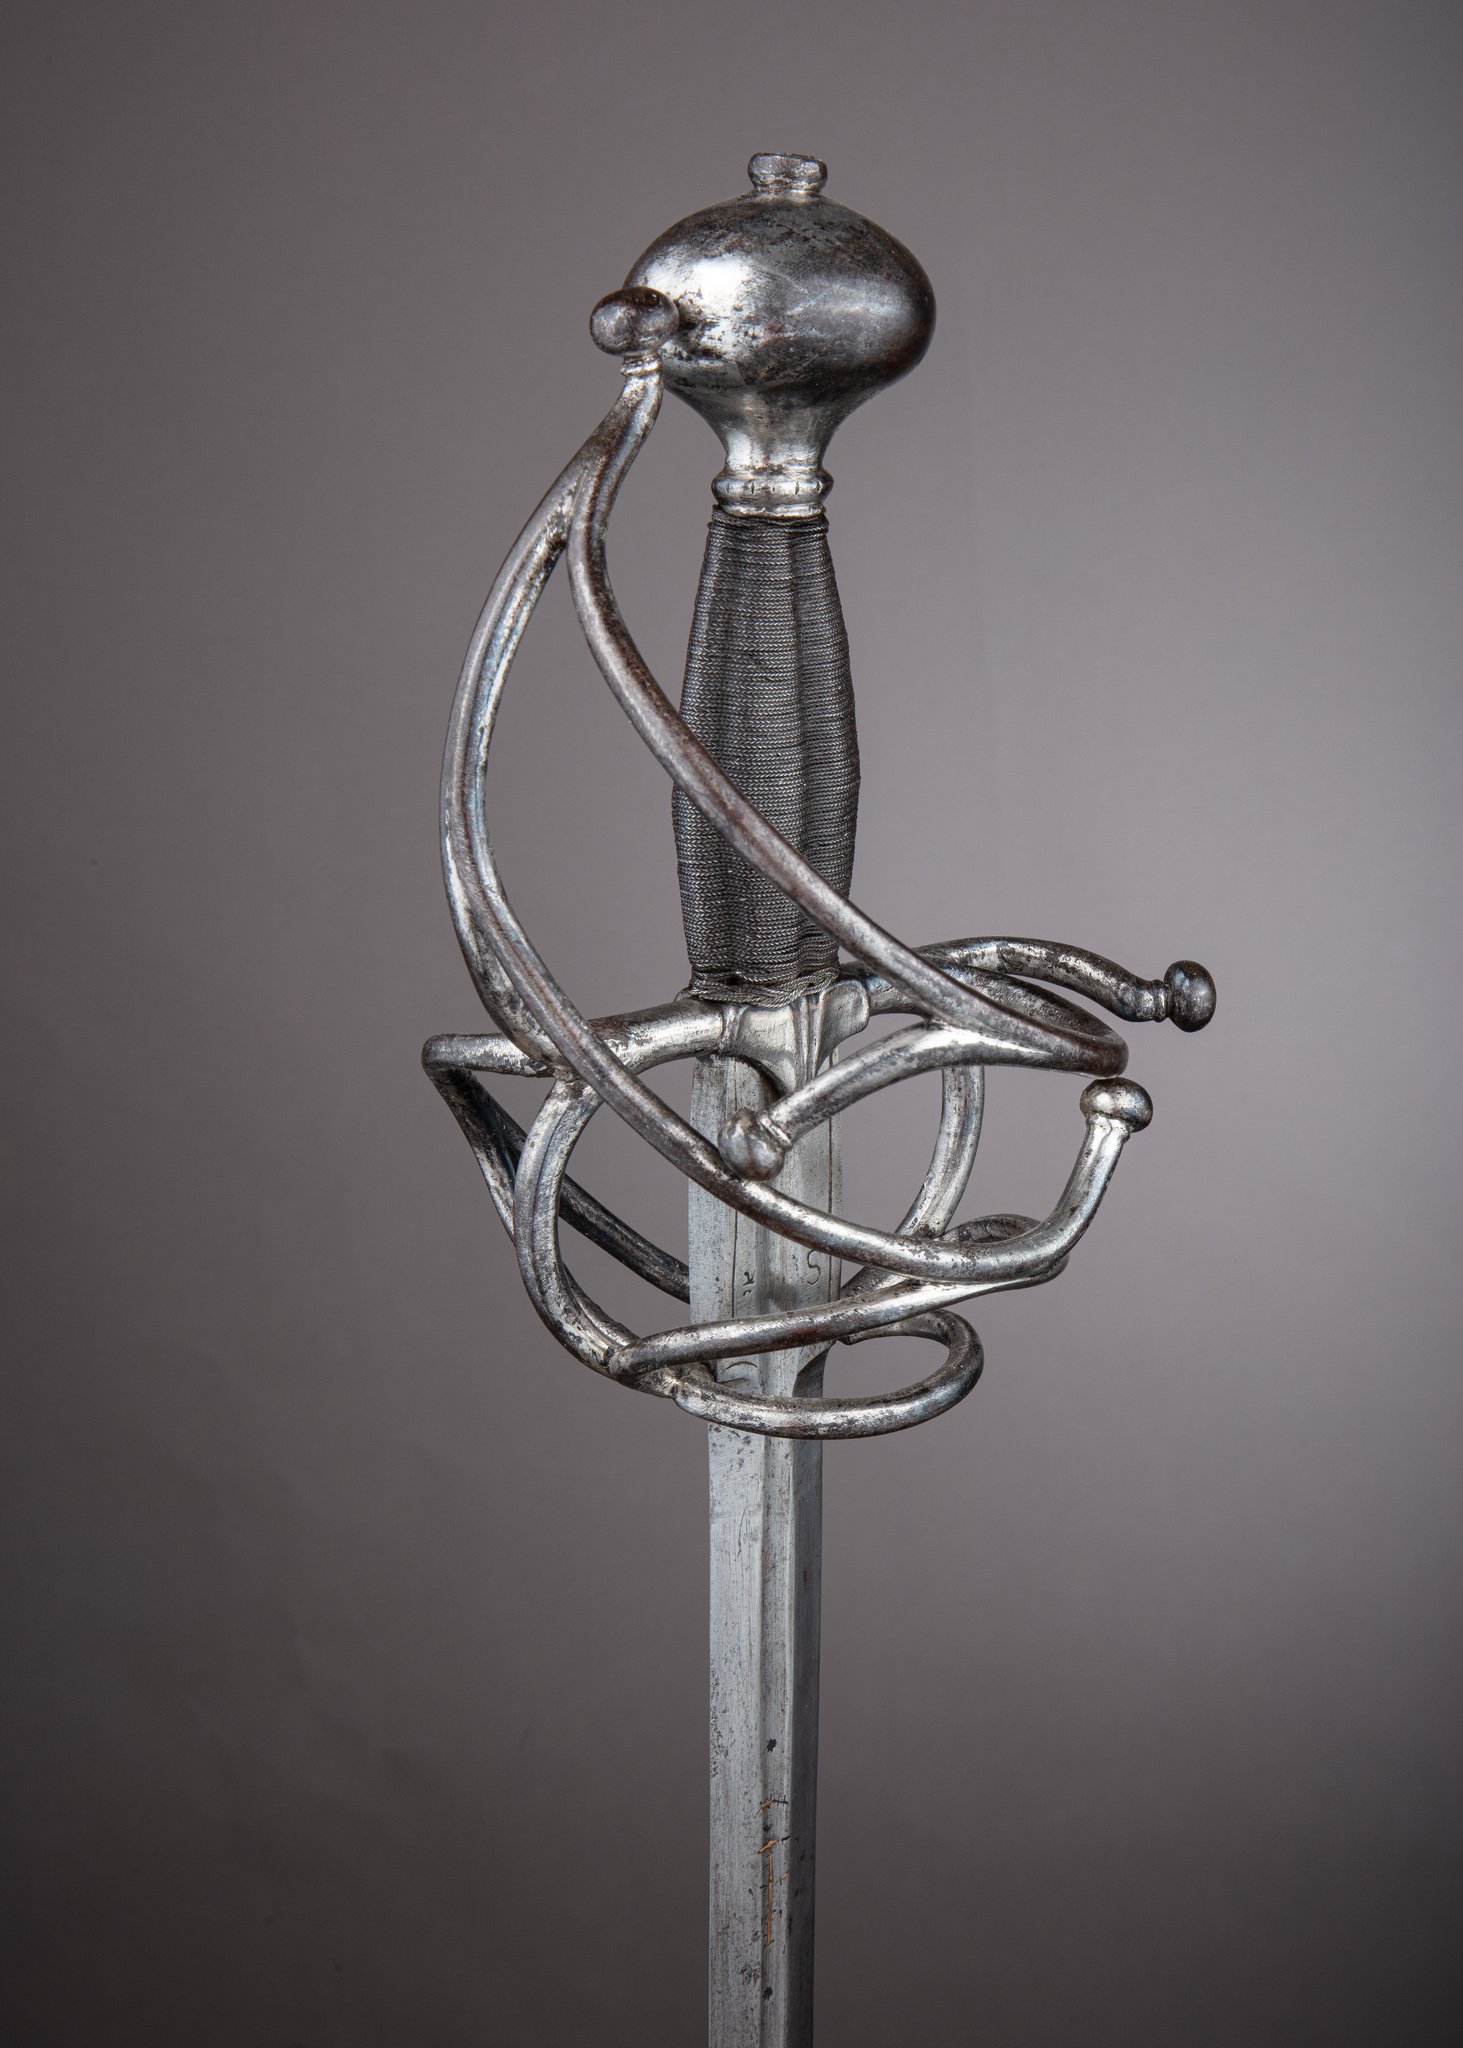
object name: rapier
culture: italian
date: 1540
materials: silver, steel, wood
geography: italy